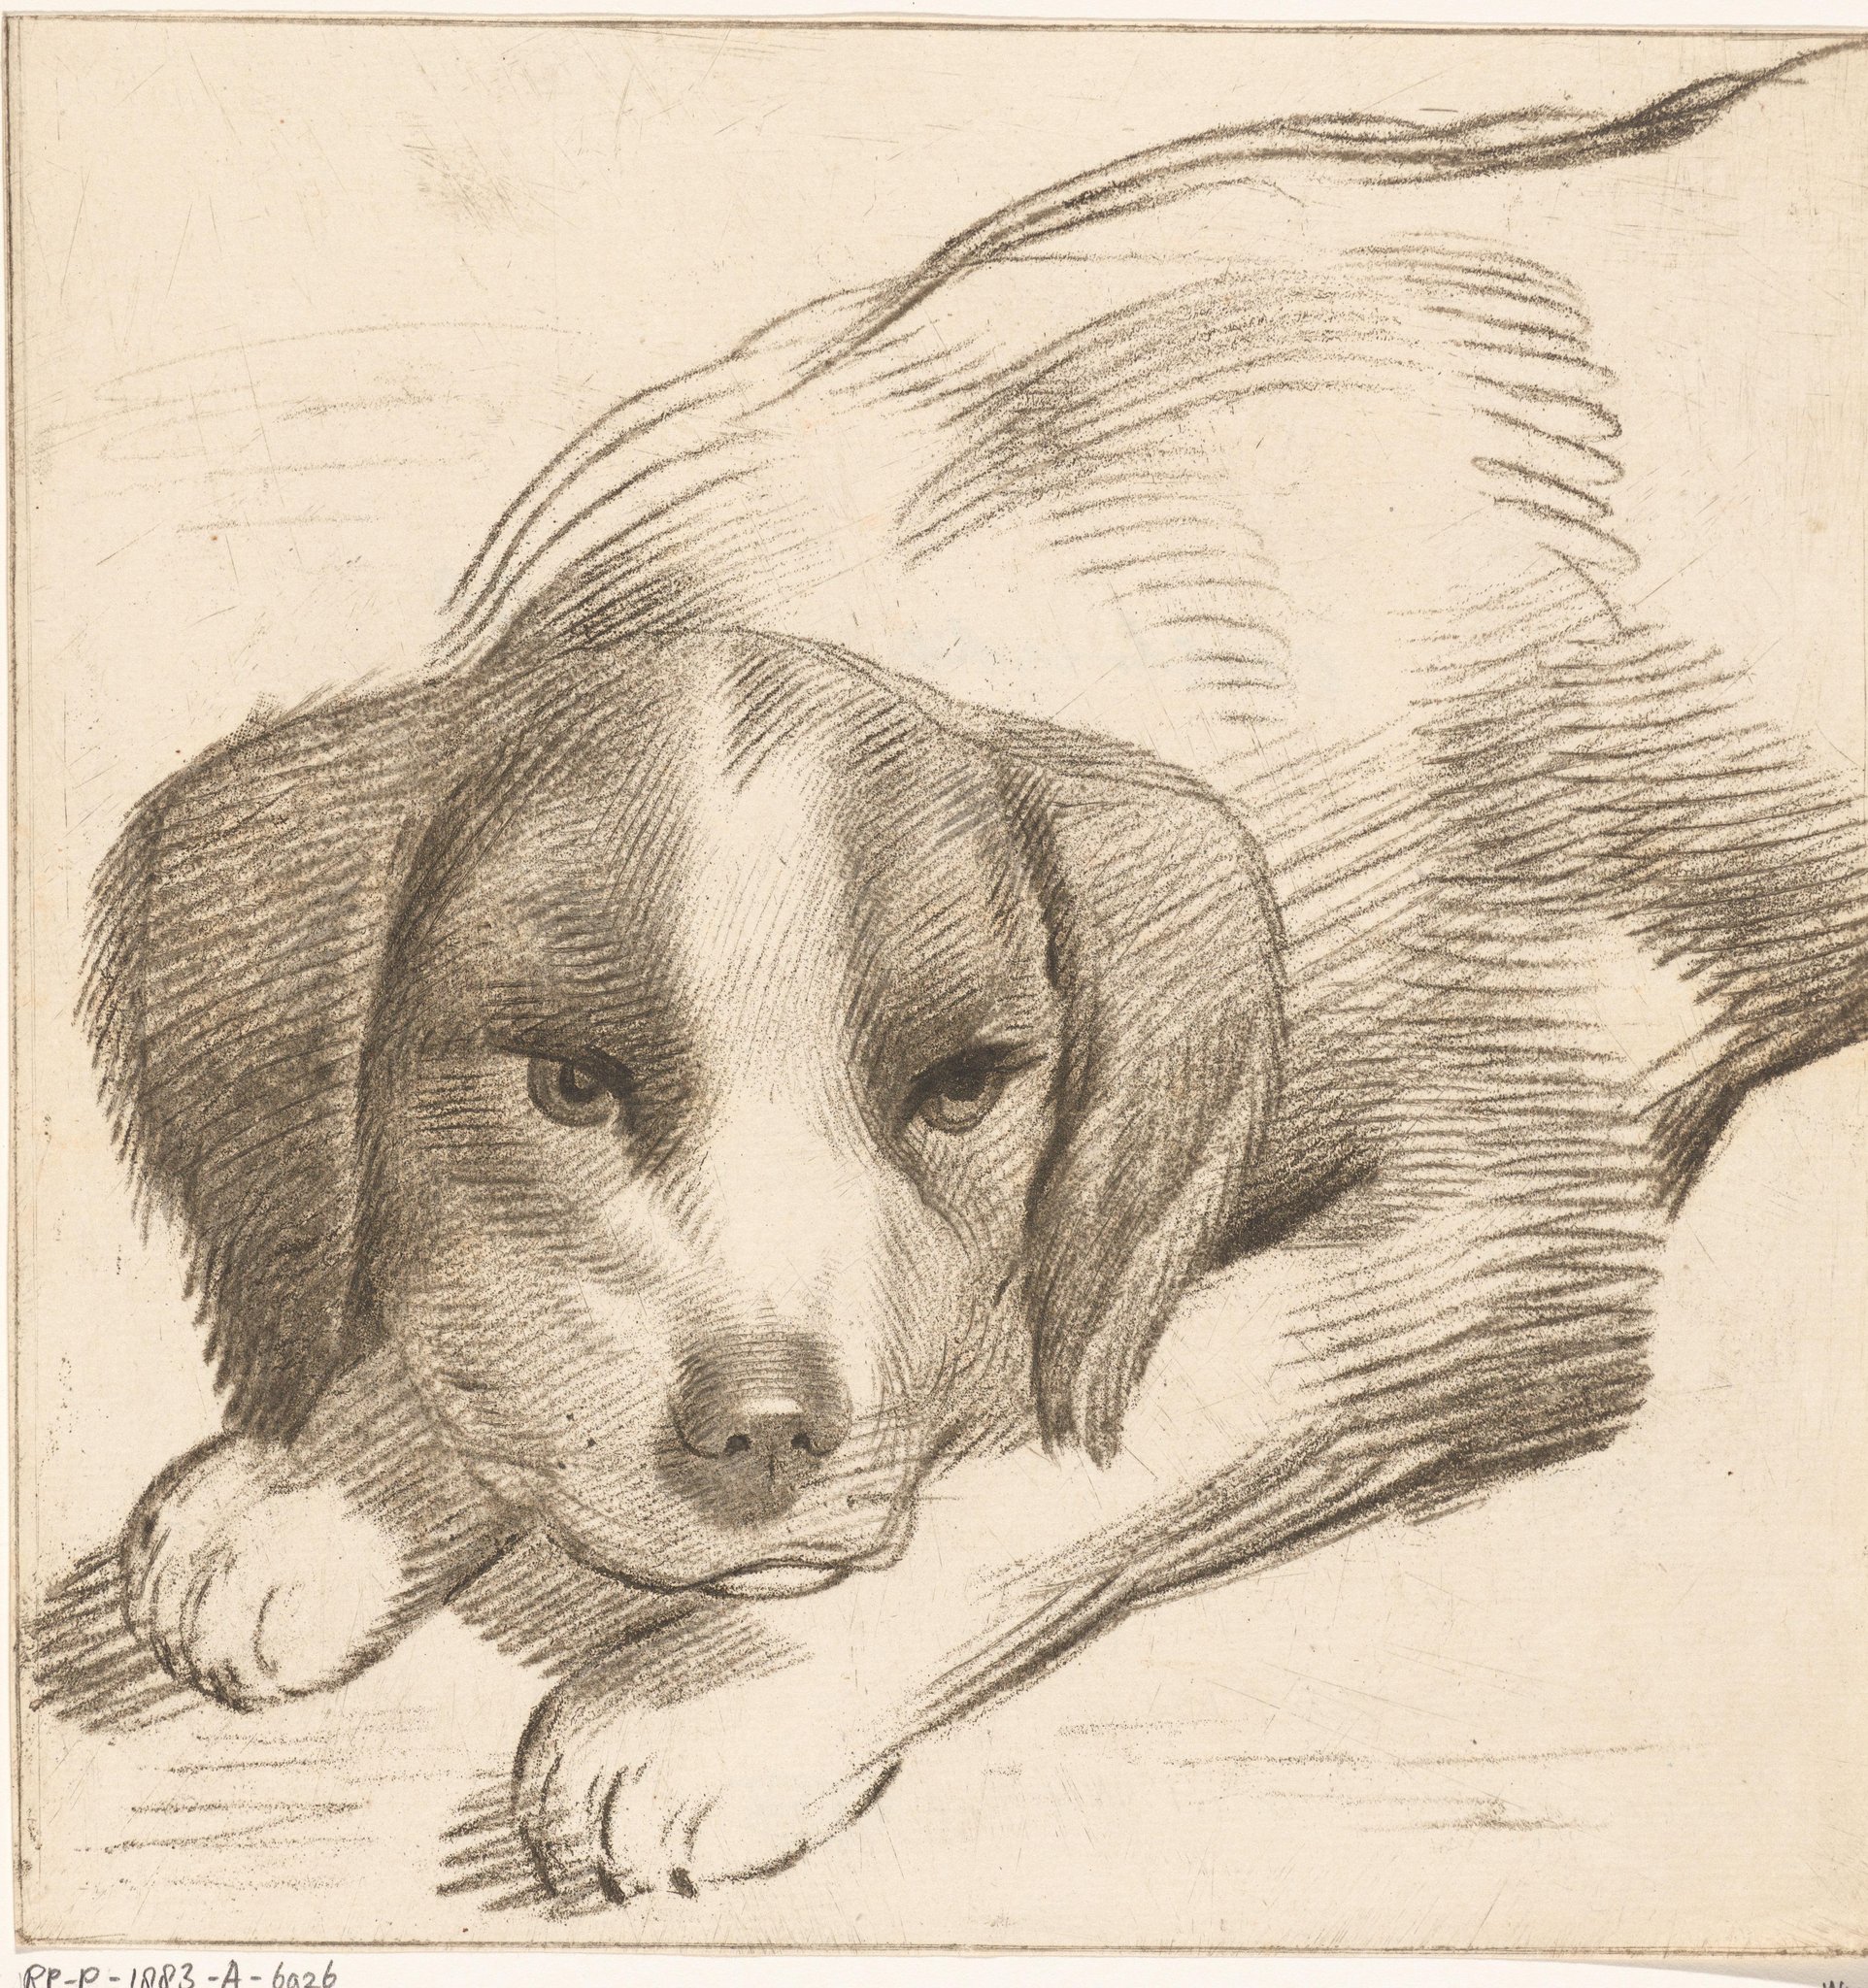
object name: print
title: Liggende hond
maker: cornelis van noorde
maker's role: draughtsman, print maker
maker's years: 1731-1795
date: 1777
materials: paper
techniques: printmaking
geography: haarlem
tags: dog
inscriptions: inscription: ‘na een Tekening van C. Visscher in 't koper gebragt door C. v. Noorde, 1777’, collector's mark: Lugt 2228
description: Een liggende hond, die zijn kop laat rusten op zijn poten.